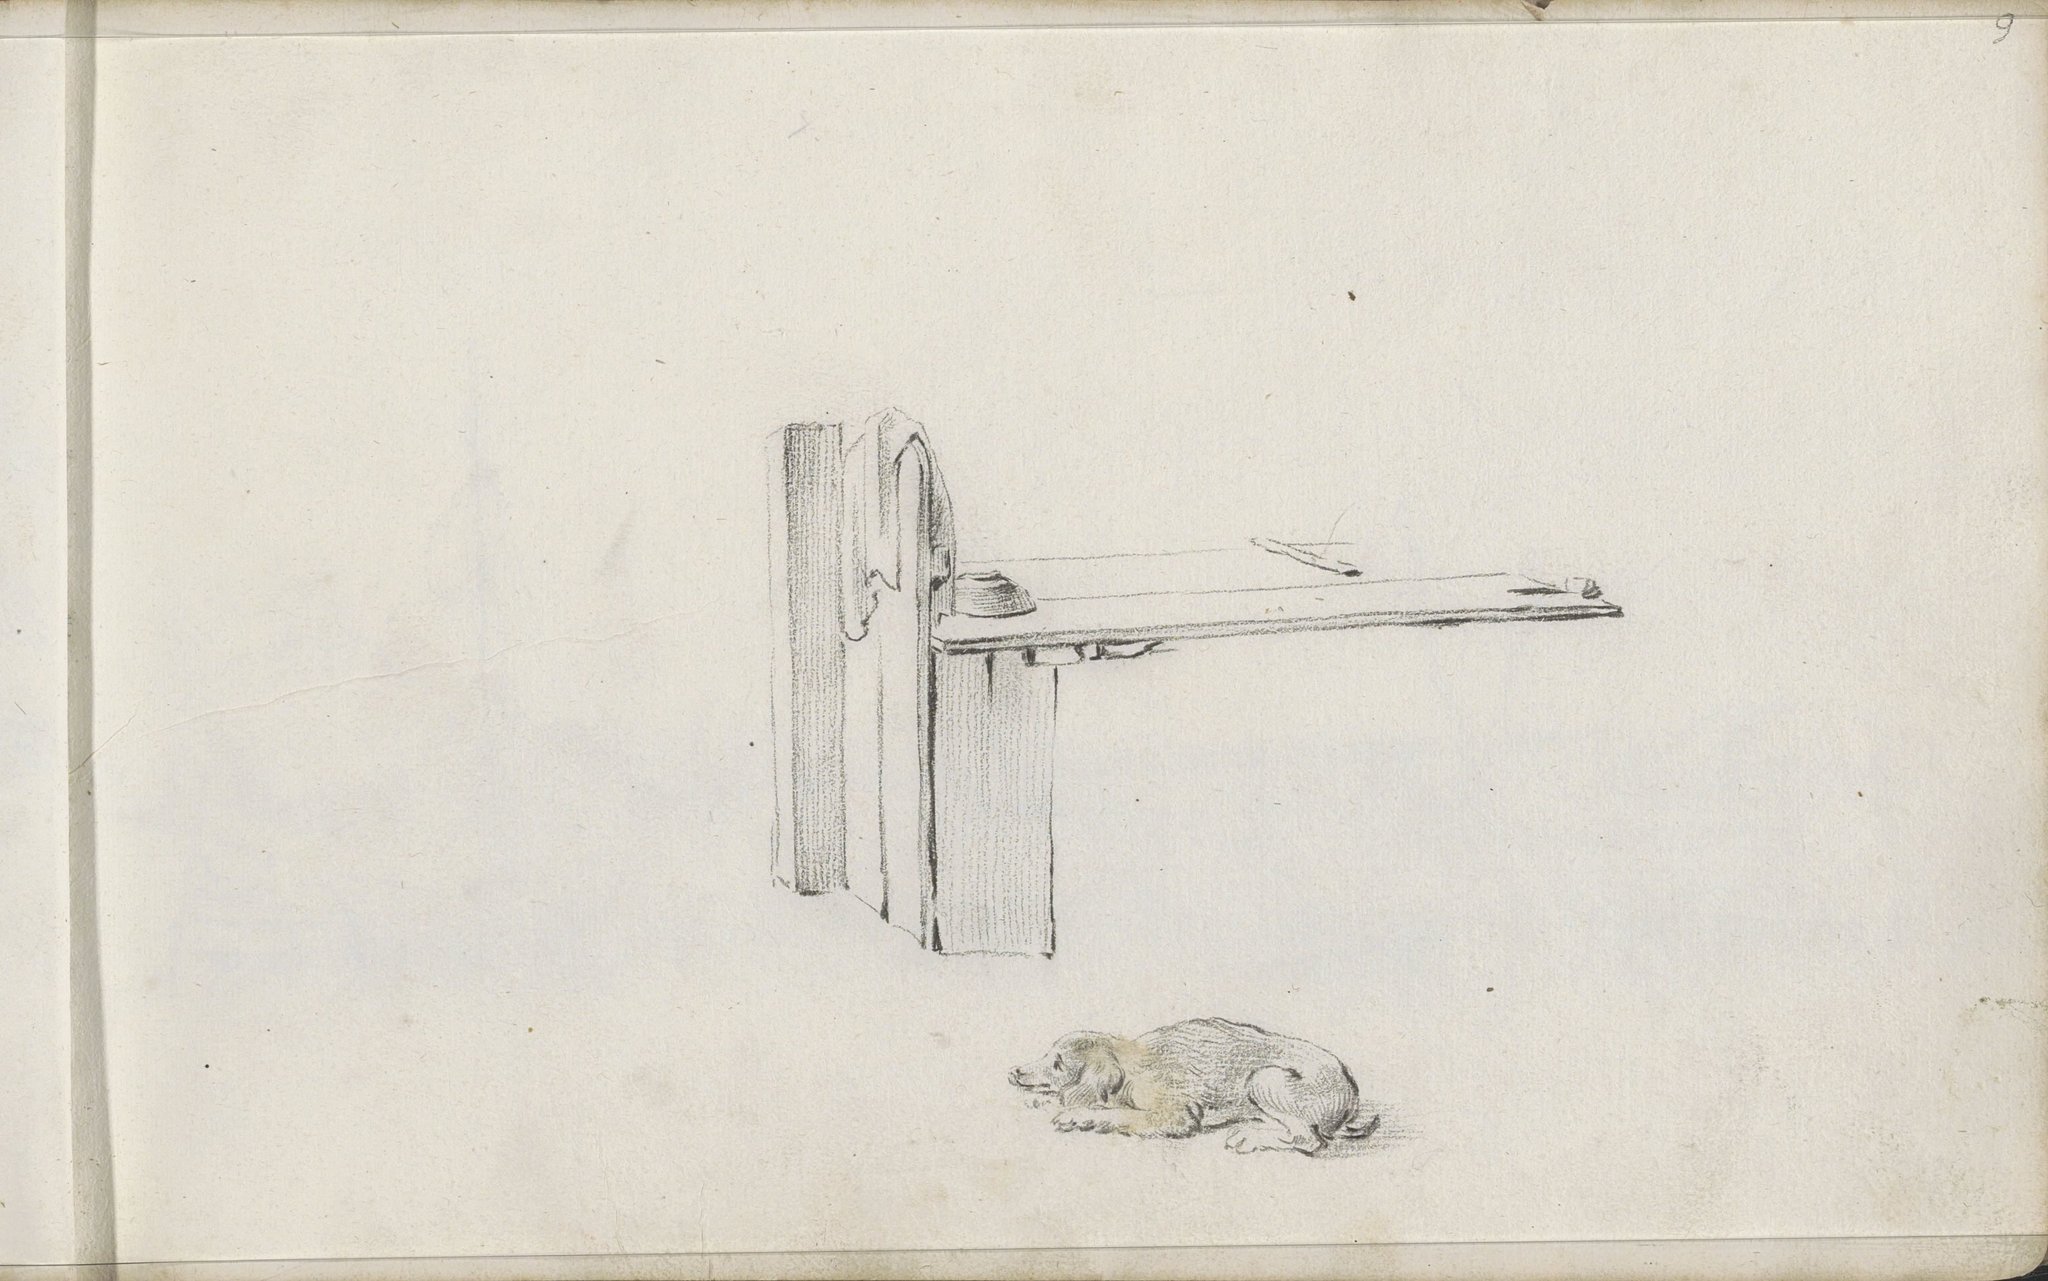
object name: sketchbook leaf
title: Liggende hond en een houten tafel of werkbank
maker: pieter moninckx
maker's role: draughtsman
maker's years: 1606-1686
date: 1645-1646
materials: chalk, paper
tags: dog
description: Blad 9 recto uit een schetsboek met 39 bladen.